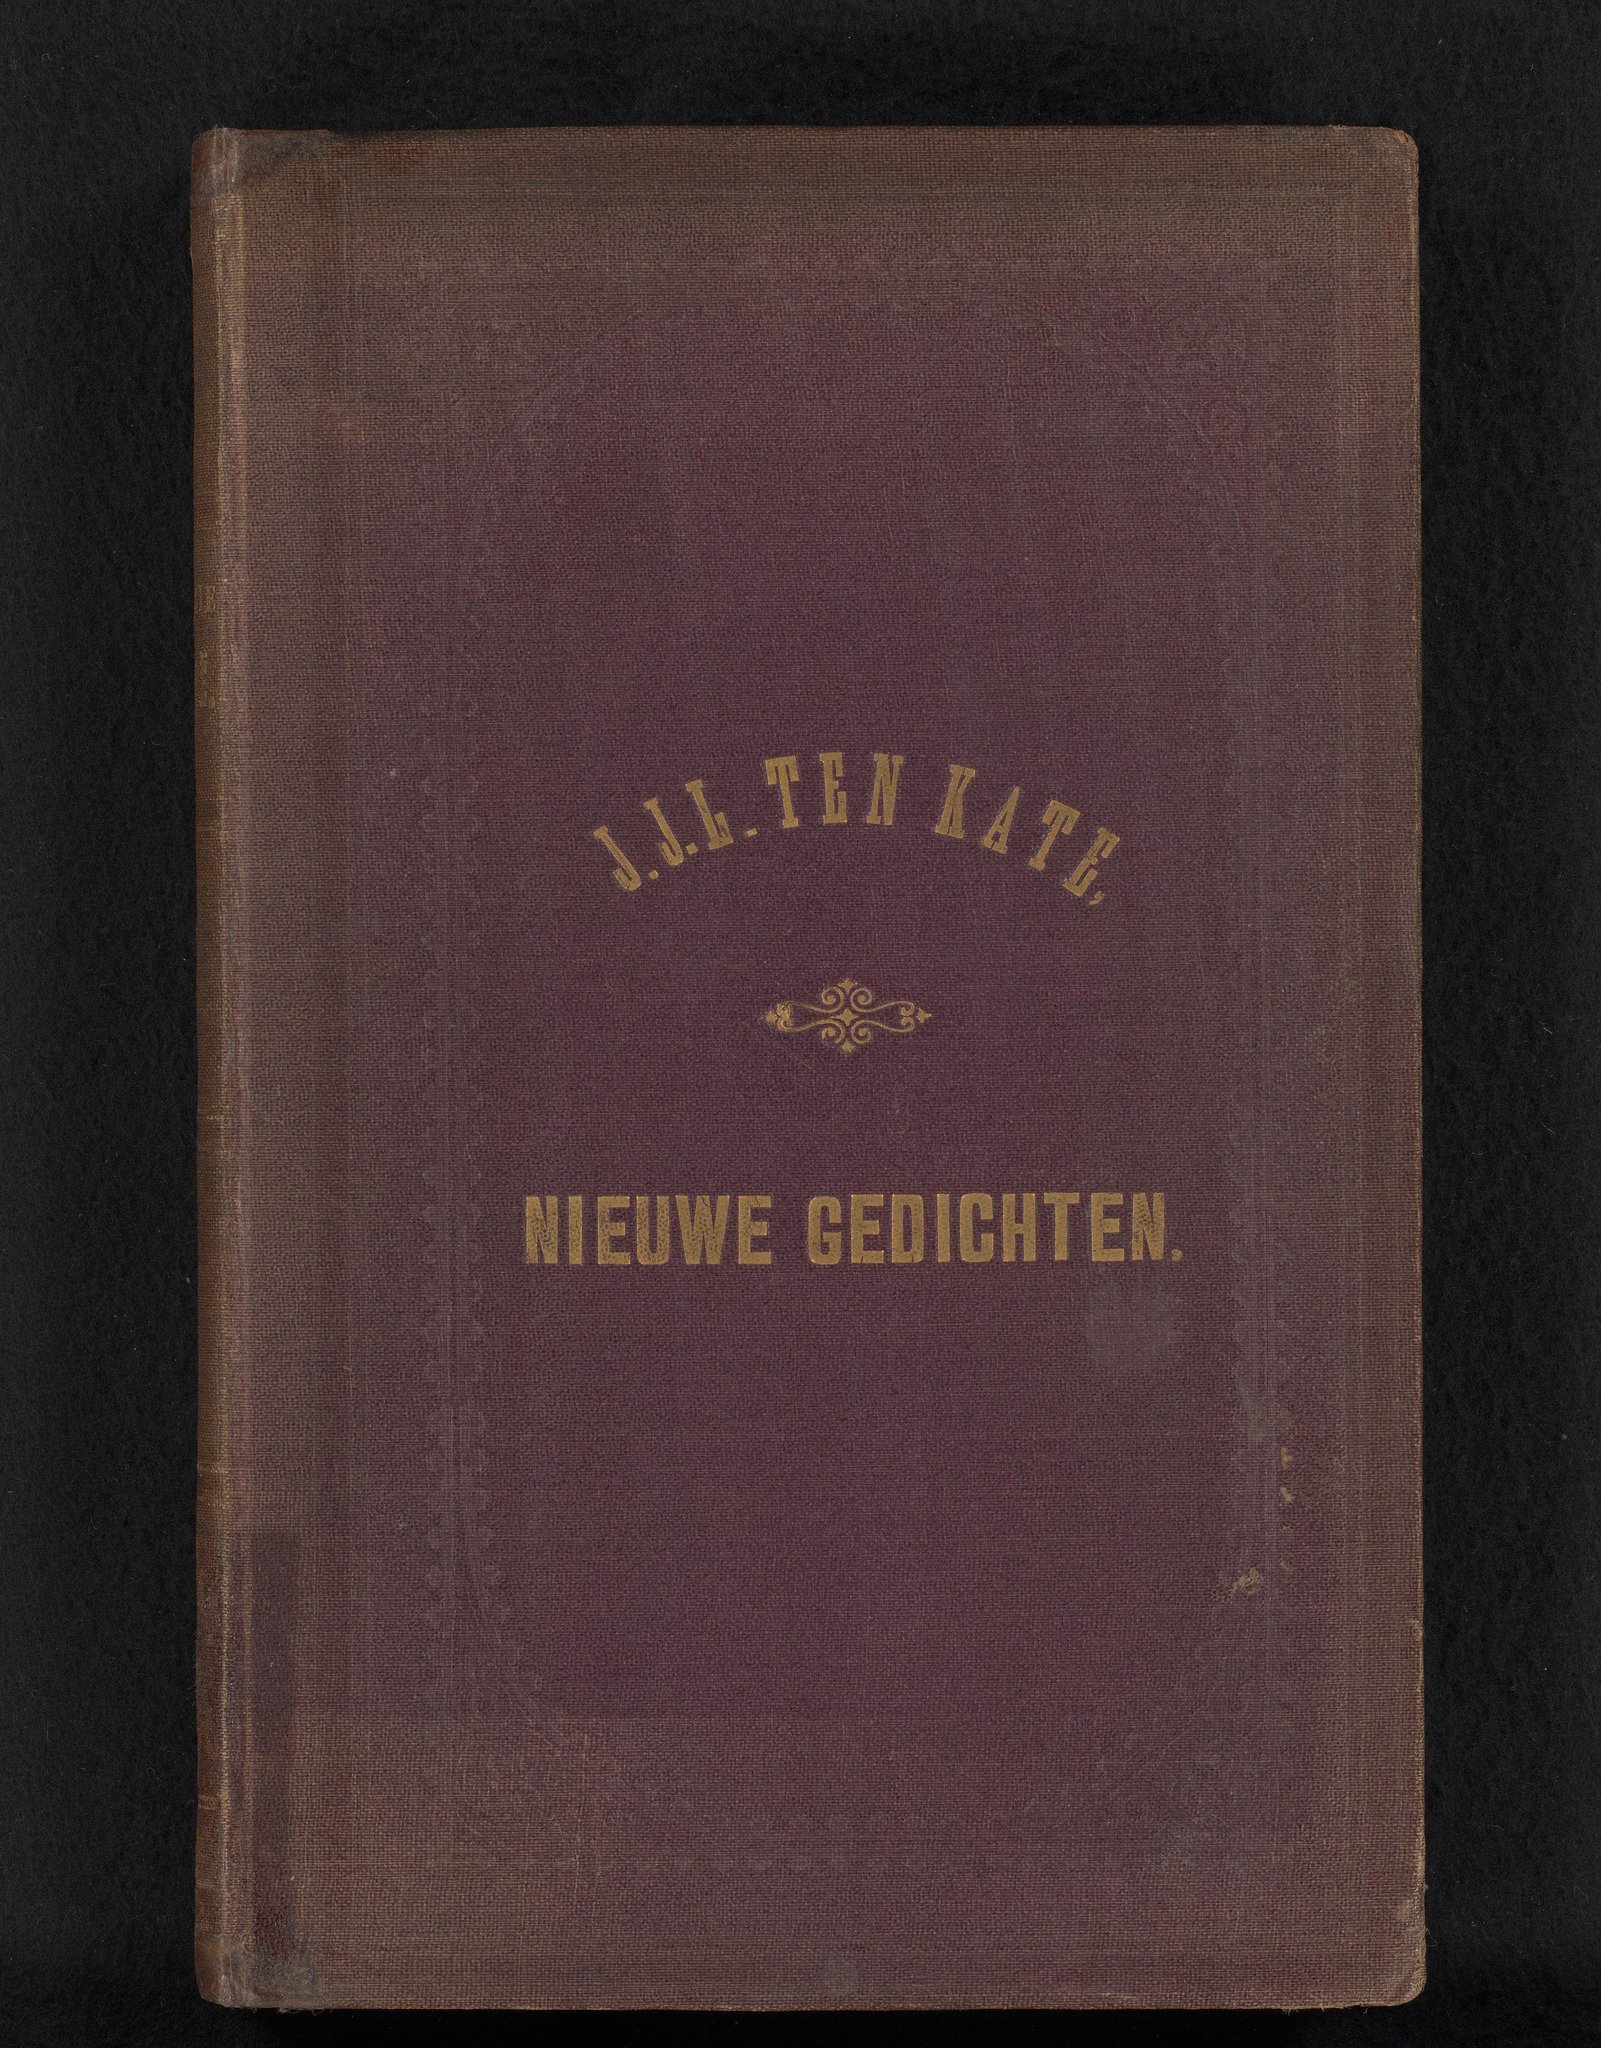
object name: book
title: Eunoë : verspreide en nieuwe gedichten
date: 1875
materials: cardboard, linen, paper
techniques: letterpress printing, woodburytype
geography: leiden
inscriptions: inscription: ‘Aan mejufrouw Landsé,/ UIt dankbare herinnering/ van Hare liefhebbende/ Leerlinge/ Antoinette ten Kate/ Amsterdam 1 September 1875’, inscription: ‘zelfde portret in Bladeren en Bloemen/ (1862?)/ gekocht bij Vanenschip, Amsterdam/ december 1964 voor f2-’